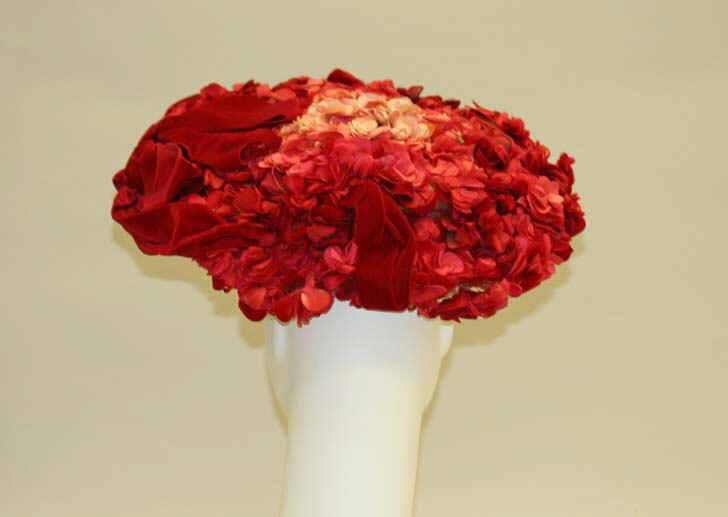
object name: hat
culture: american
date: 1900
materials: metal, silk